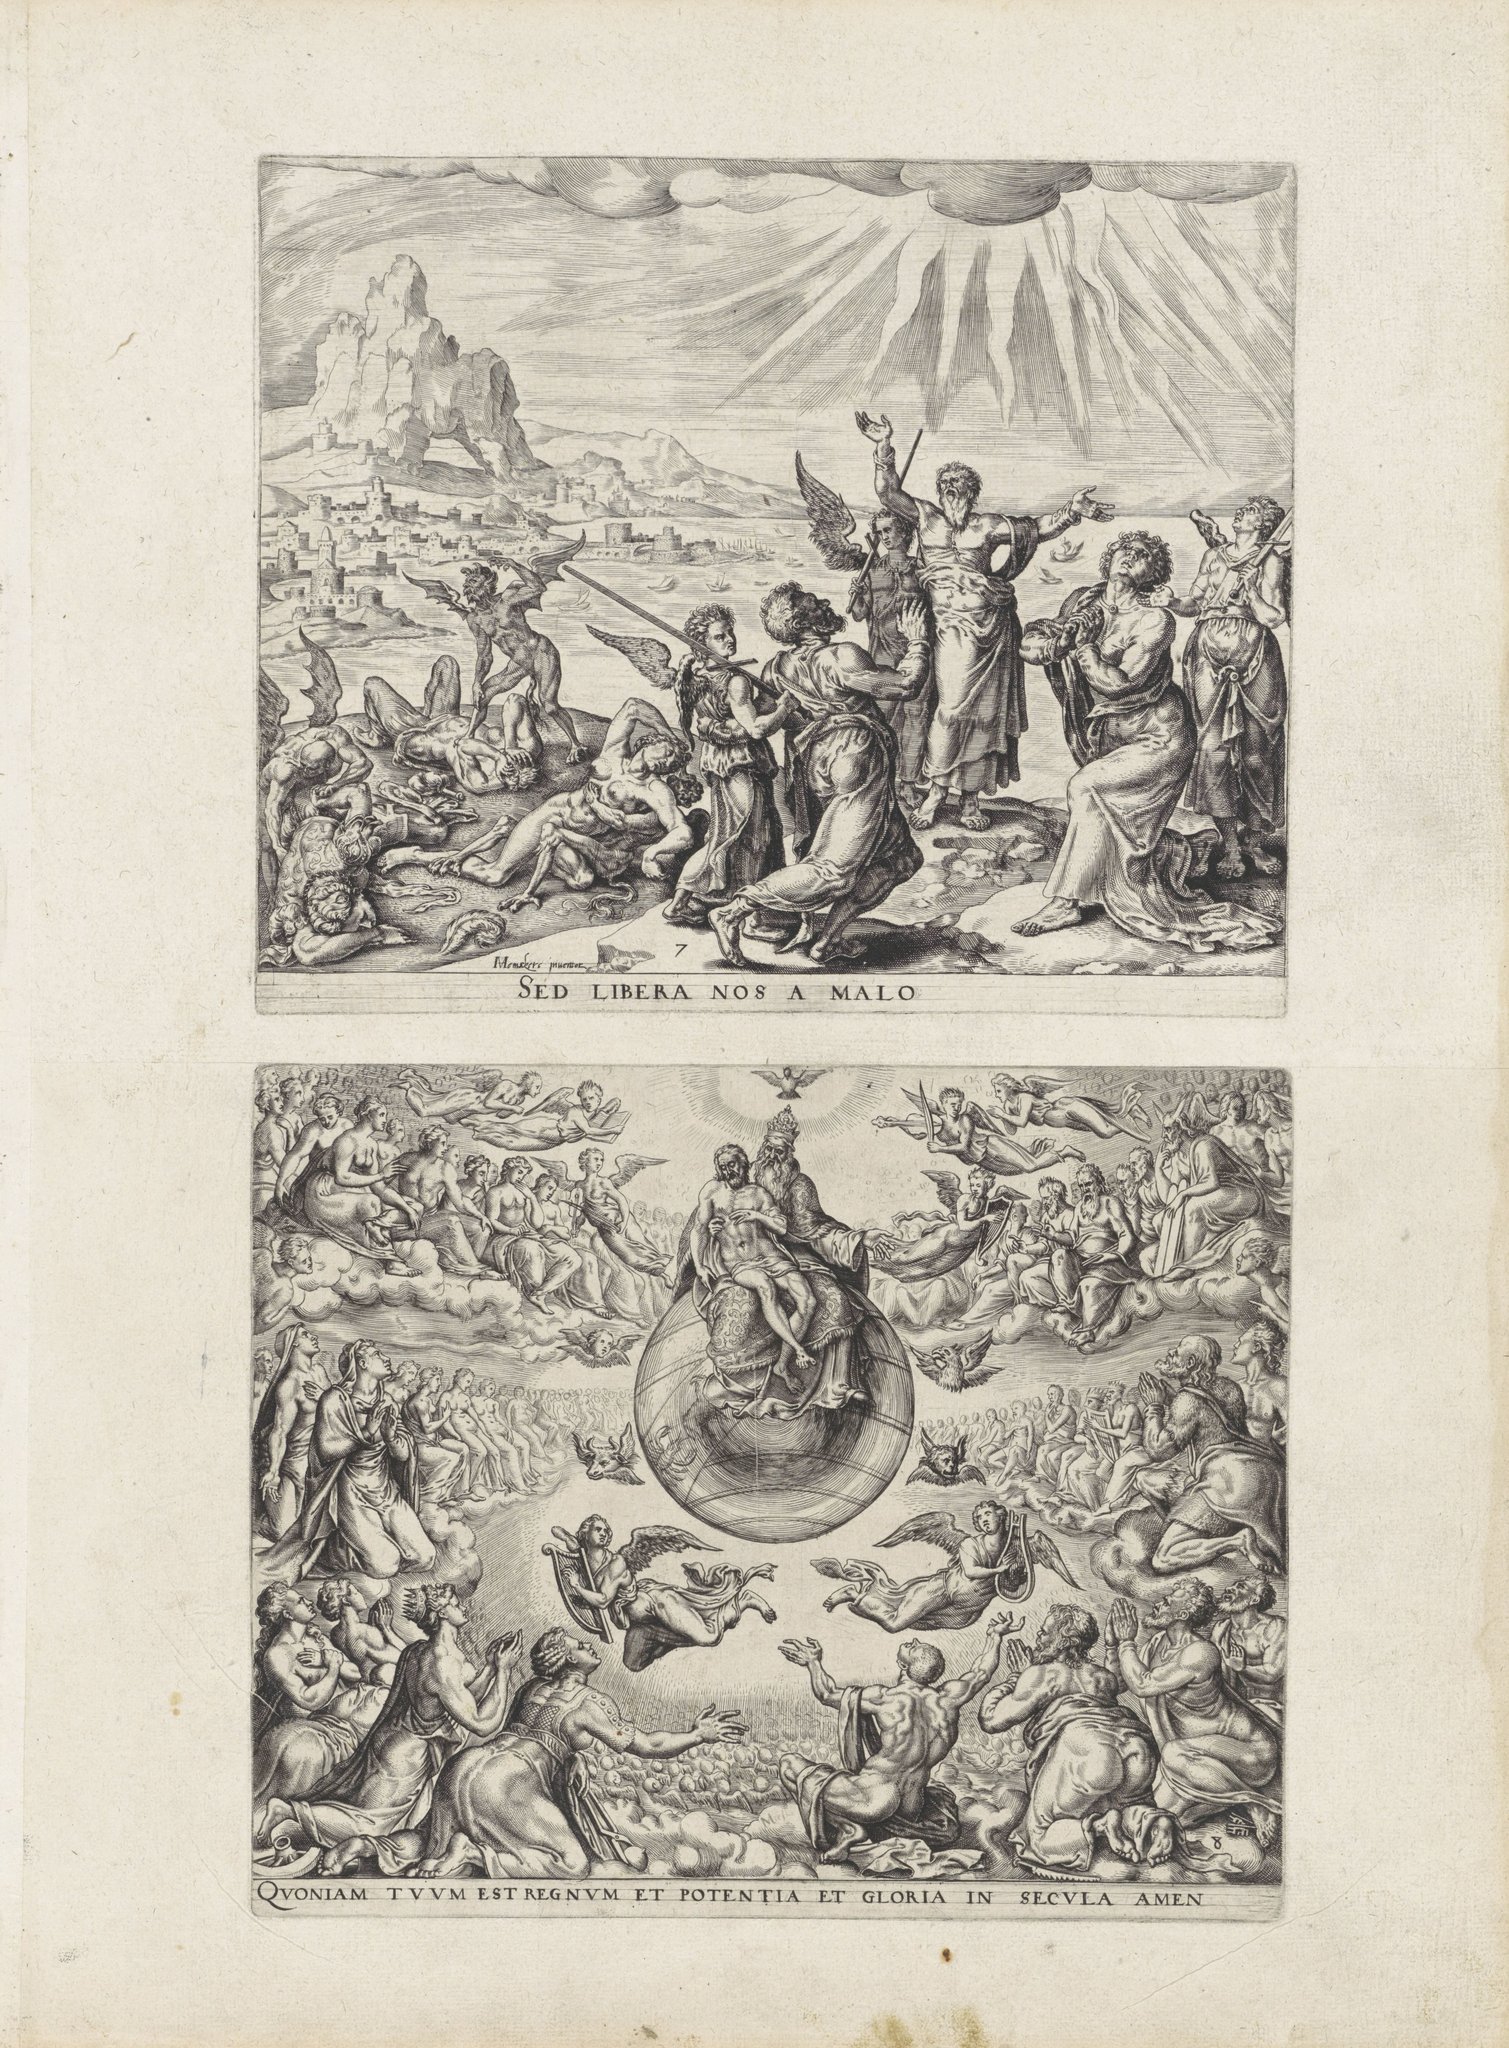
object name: print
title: Onze Vader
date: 1569-1573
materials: paper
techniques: engraving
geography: antwerp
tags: god the father holding the crucified or dead christ (+ angels floating in the air), the four symbols of the evangelists, 'the apocalyptic beasts', 'but deliver us from evil' ~ the lord's prayer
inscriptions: caption: ‘QUONIAM TUUM EST REGNUM ET POTENTIA ET GLORIA IN SECULA AMEN’ Lugt, collector's mark: Lugt 2228, collector's mark: 2760, caption: ‘SED LIBERA NOS A MALO’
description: Blad met twee prenten uit een serie, oorspronkelijk als album gebonden. Boven: Mensen bidden richting de hemel. Ze worden door engelen bevrijdt van het kwaad. Stralen schijnen vanuit de hemel op hen. Het Latijnse onderschrift is een deel uit het gebed het Onze Vader. Onder: De Drieëenheid wordt aanbeden door mensen en engelen. God de Vader zit op een globe met zijn gekruisigde zoon Christus op schoot. Boven hen de duif van de Heilige Geest. Rond de globe de symbolen van de vier evangelisten (de apocalyptische dieren) en musicerende engelen.